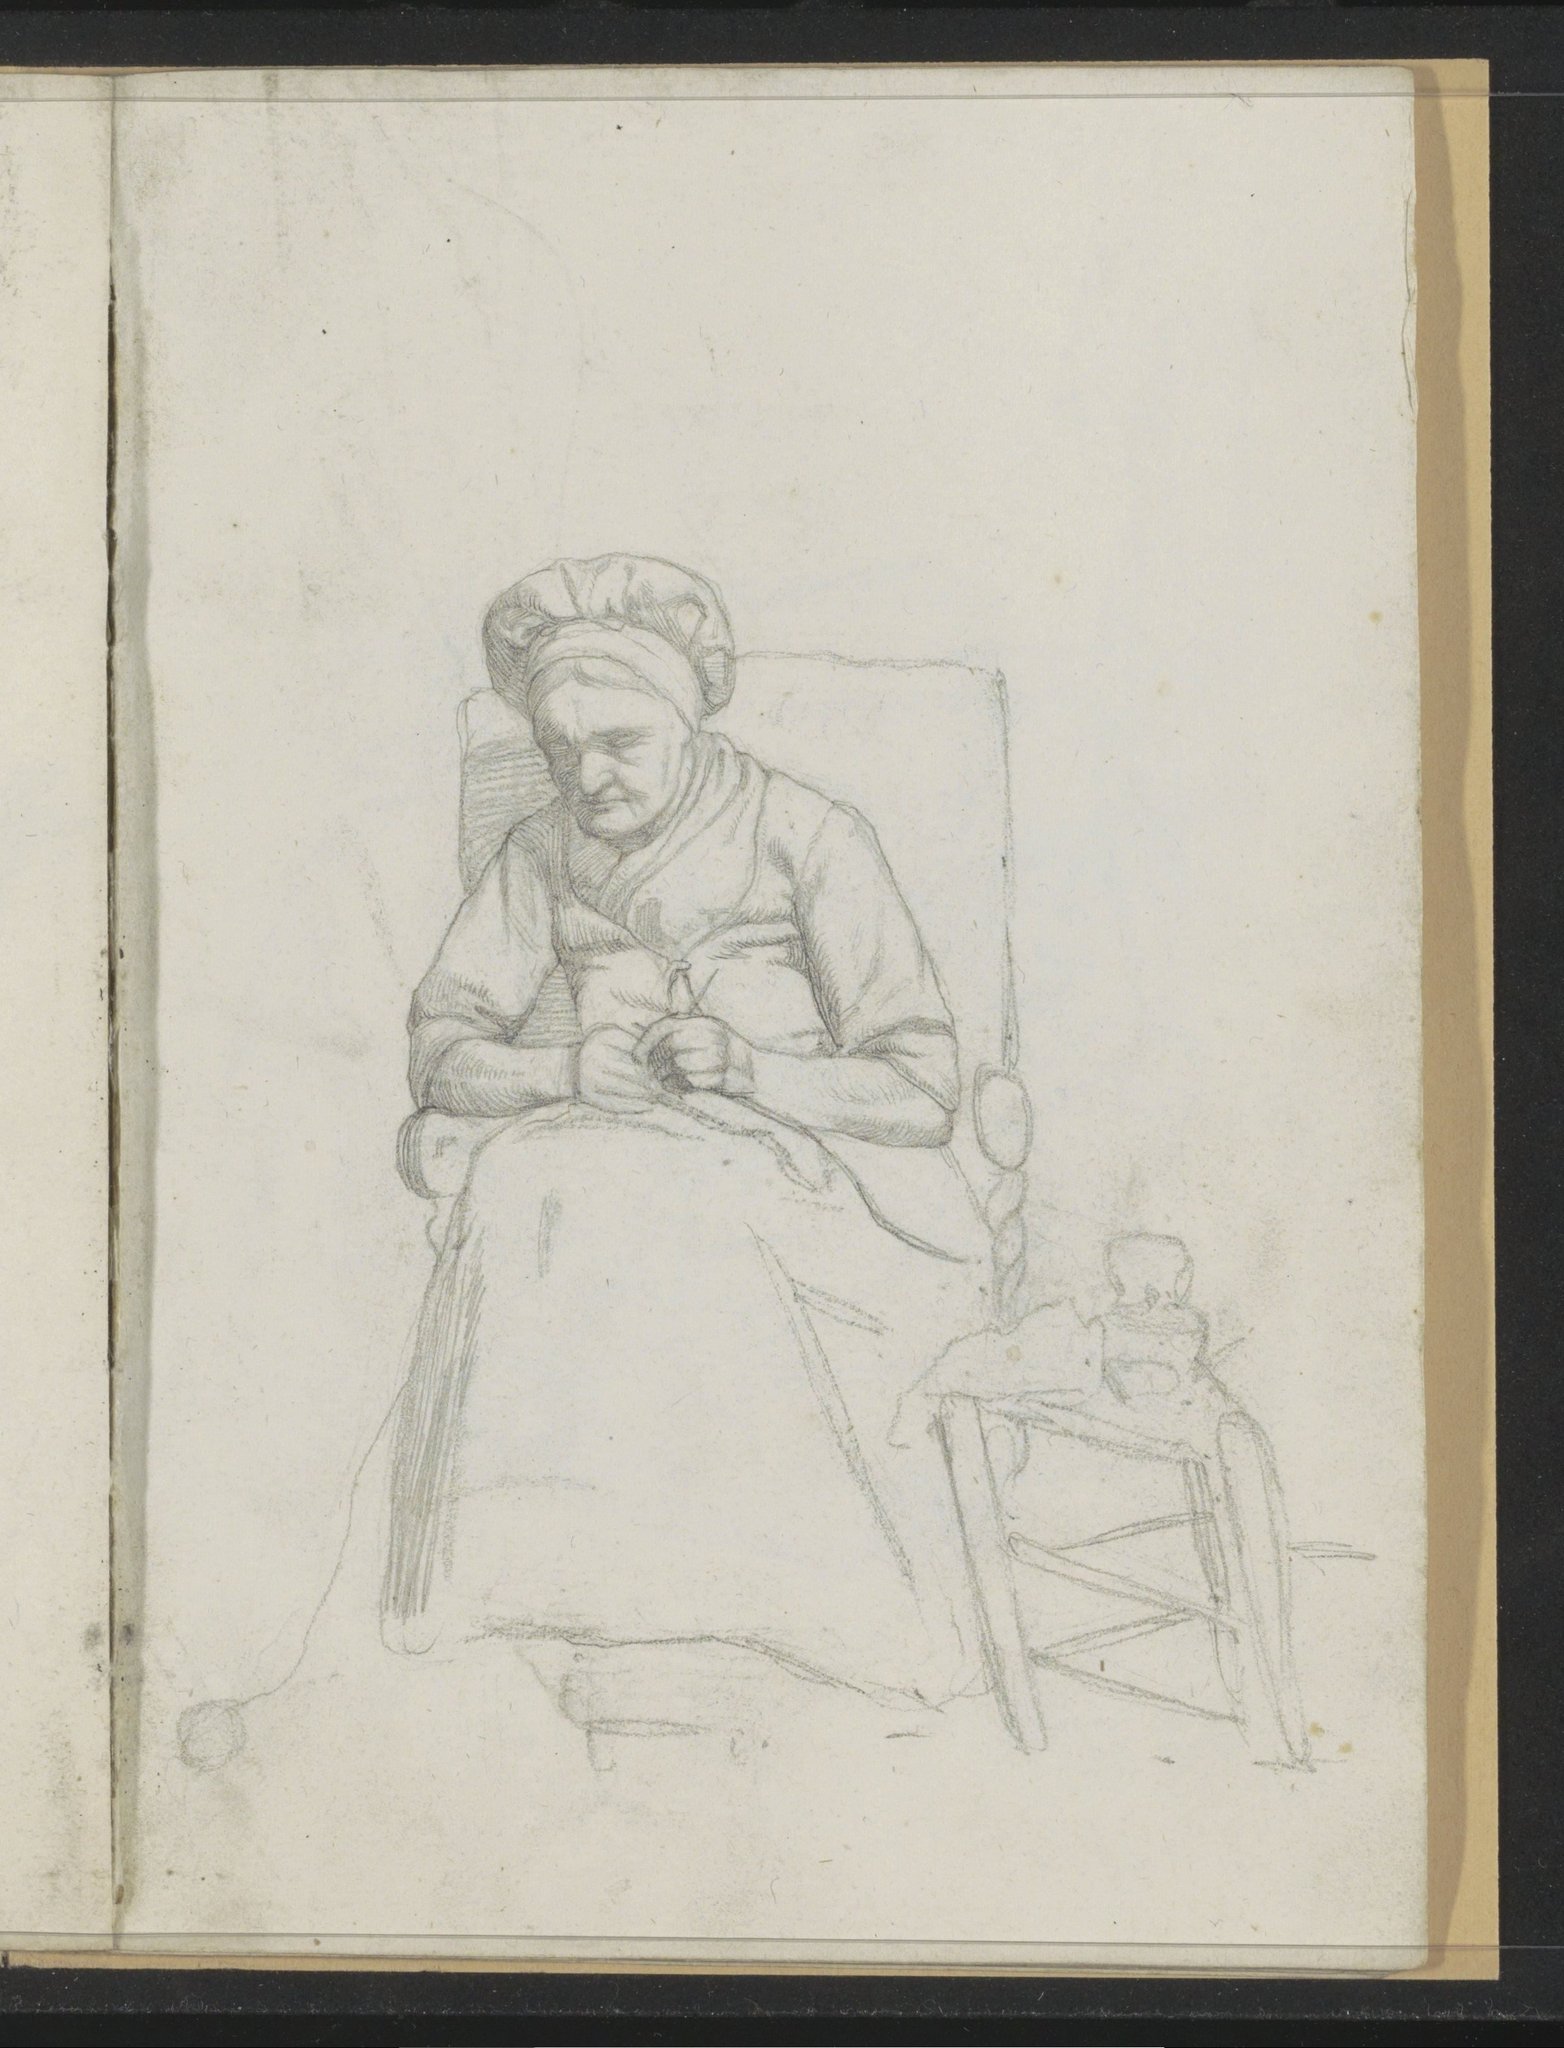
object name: sketchbook leaf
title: Breiende oude vrouw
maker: jozef israëls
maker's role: draughtsman, painter, print maker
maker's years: 1824-1911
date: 1834-1911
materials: paper, pencil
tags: sitting figure (+ old female (human being)), knitting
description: De vrouw zit in een stoel met een tafel en een bol wol naast haar op de grond. Blad 5 recto uit een schetsboek met 16 bladen.